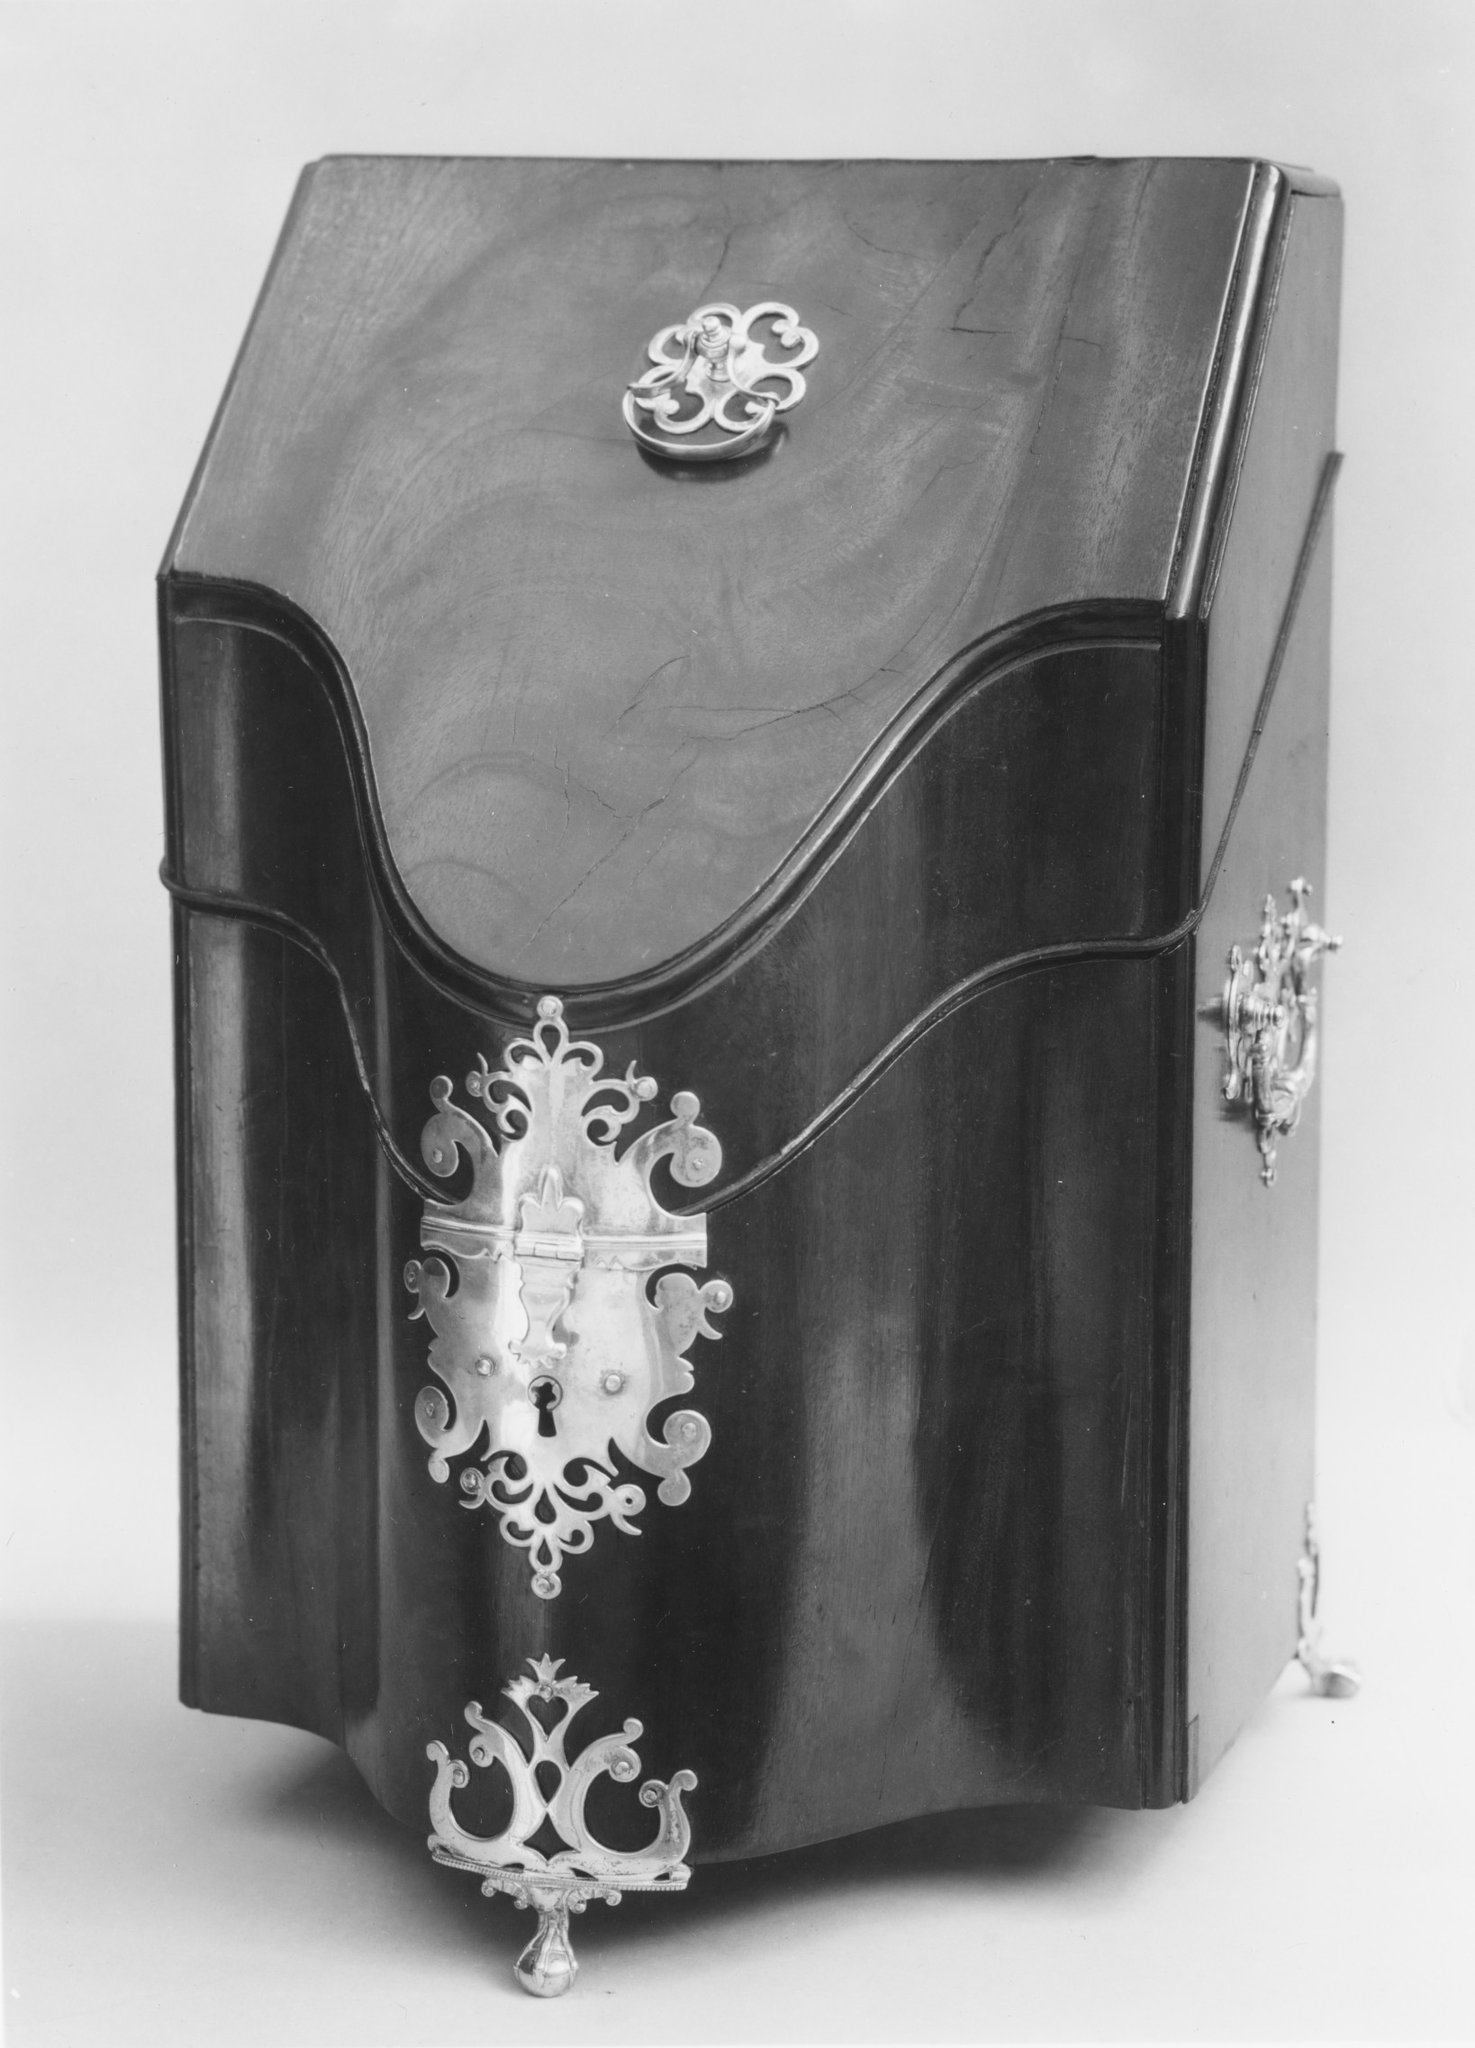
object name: knife box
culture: american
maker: lewis fueter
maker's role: maker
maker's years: 1766-1775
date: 1765-1795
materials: wood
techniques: veneering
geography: united states